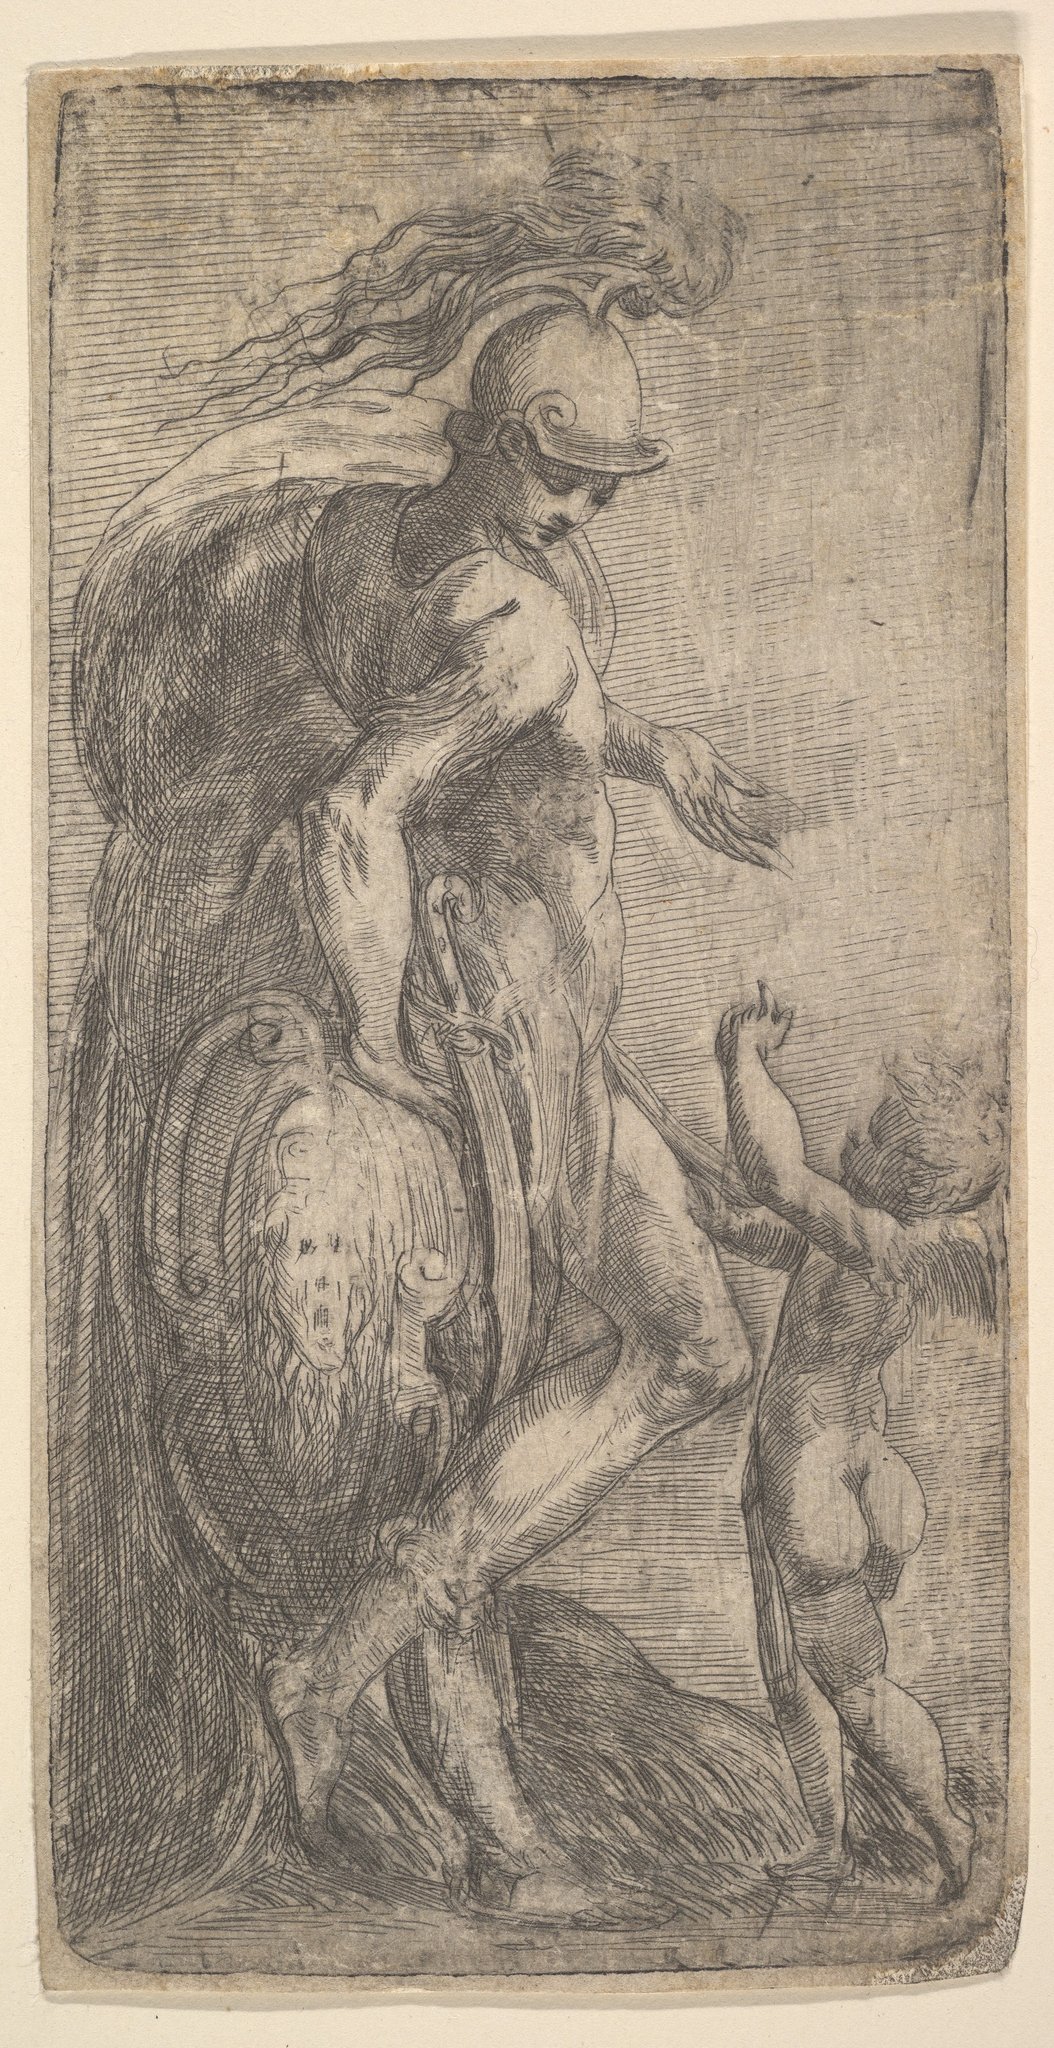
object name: print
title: Mars standing at the left leaning on a shield, Cupid at the right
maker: andrea schiavone (andrea meldola)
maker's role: artist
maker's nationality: italian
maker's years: 1510-1563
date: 1542-1546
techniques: etching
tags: shields,cupid,mars